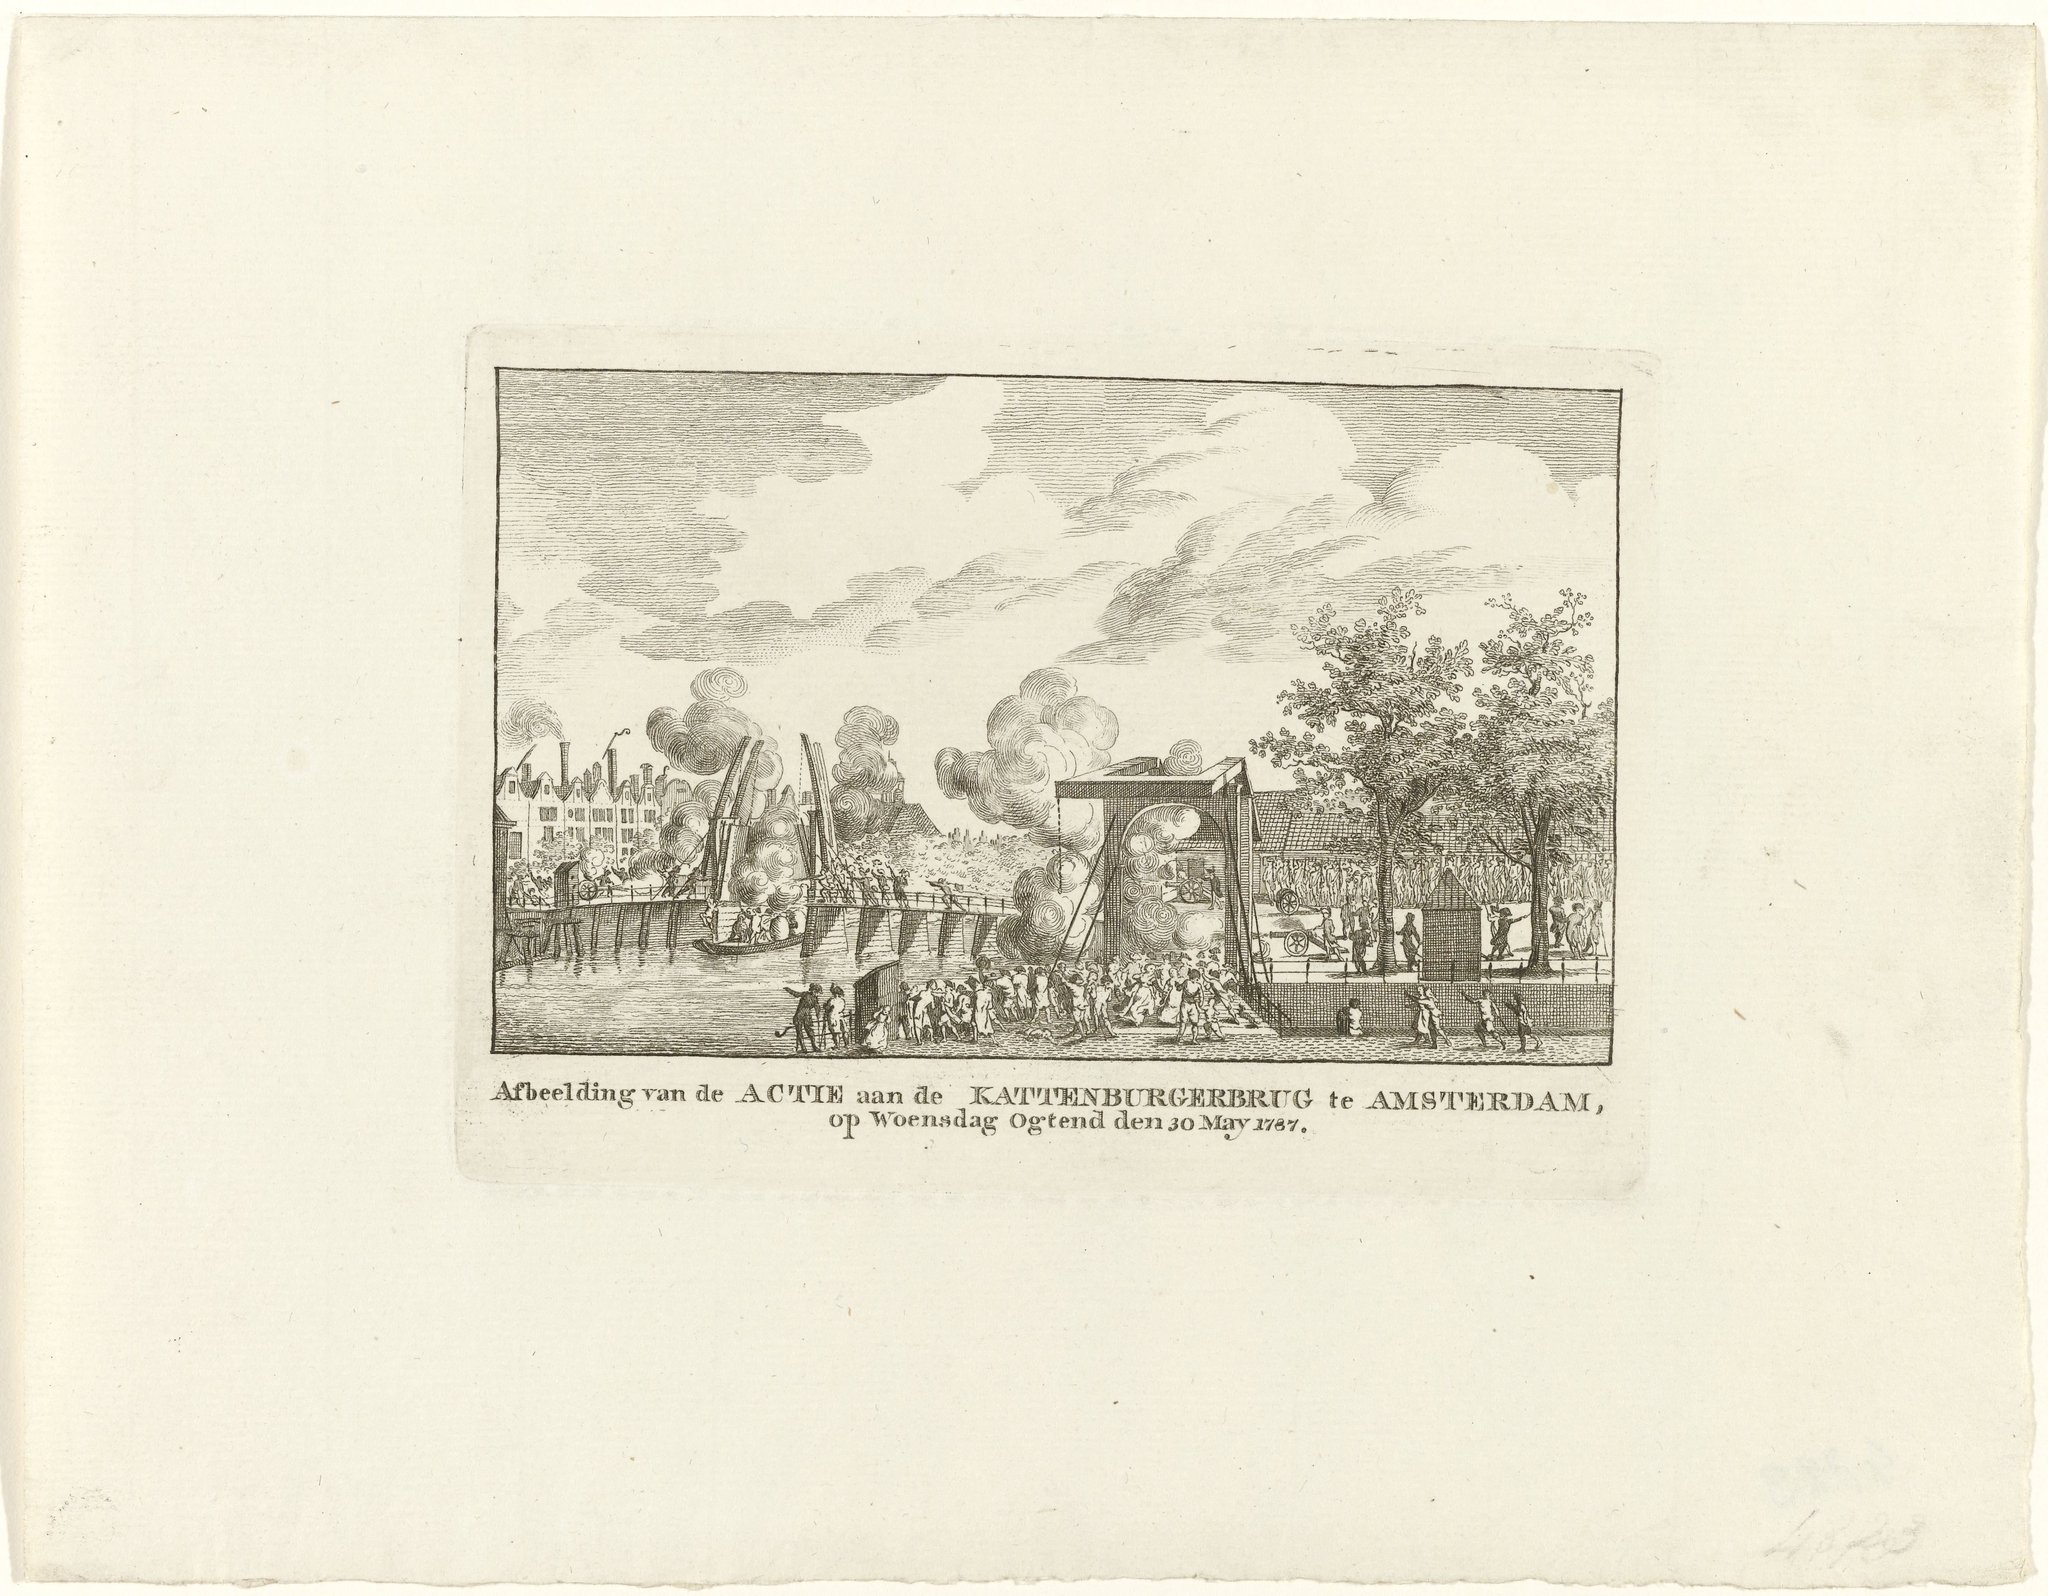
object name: print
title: Verovering van de Kattenburgerbrug, 1787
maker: Anonymous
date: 1787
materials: paper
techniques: etching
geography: northern netherlands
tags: battle (+ citizen soldiery, civil guard, citizen militia)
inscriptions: collector's mark: Lugt 2228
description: De verovering van de Kattenburgerbrug naar het eiland Kattenburg op de opstandige Oranjegezinden door de gewapende Amsterdamse burgers, 30 mei 1787.